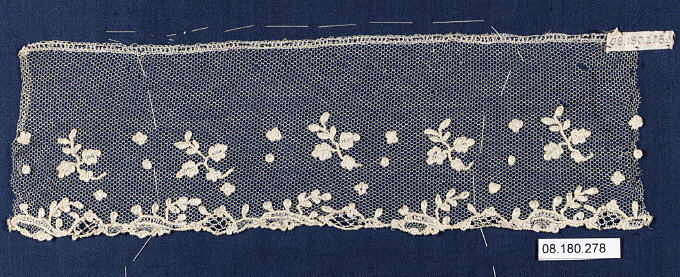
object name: fragment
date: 1701-1800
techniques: lace